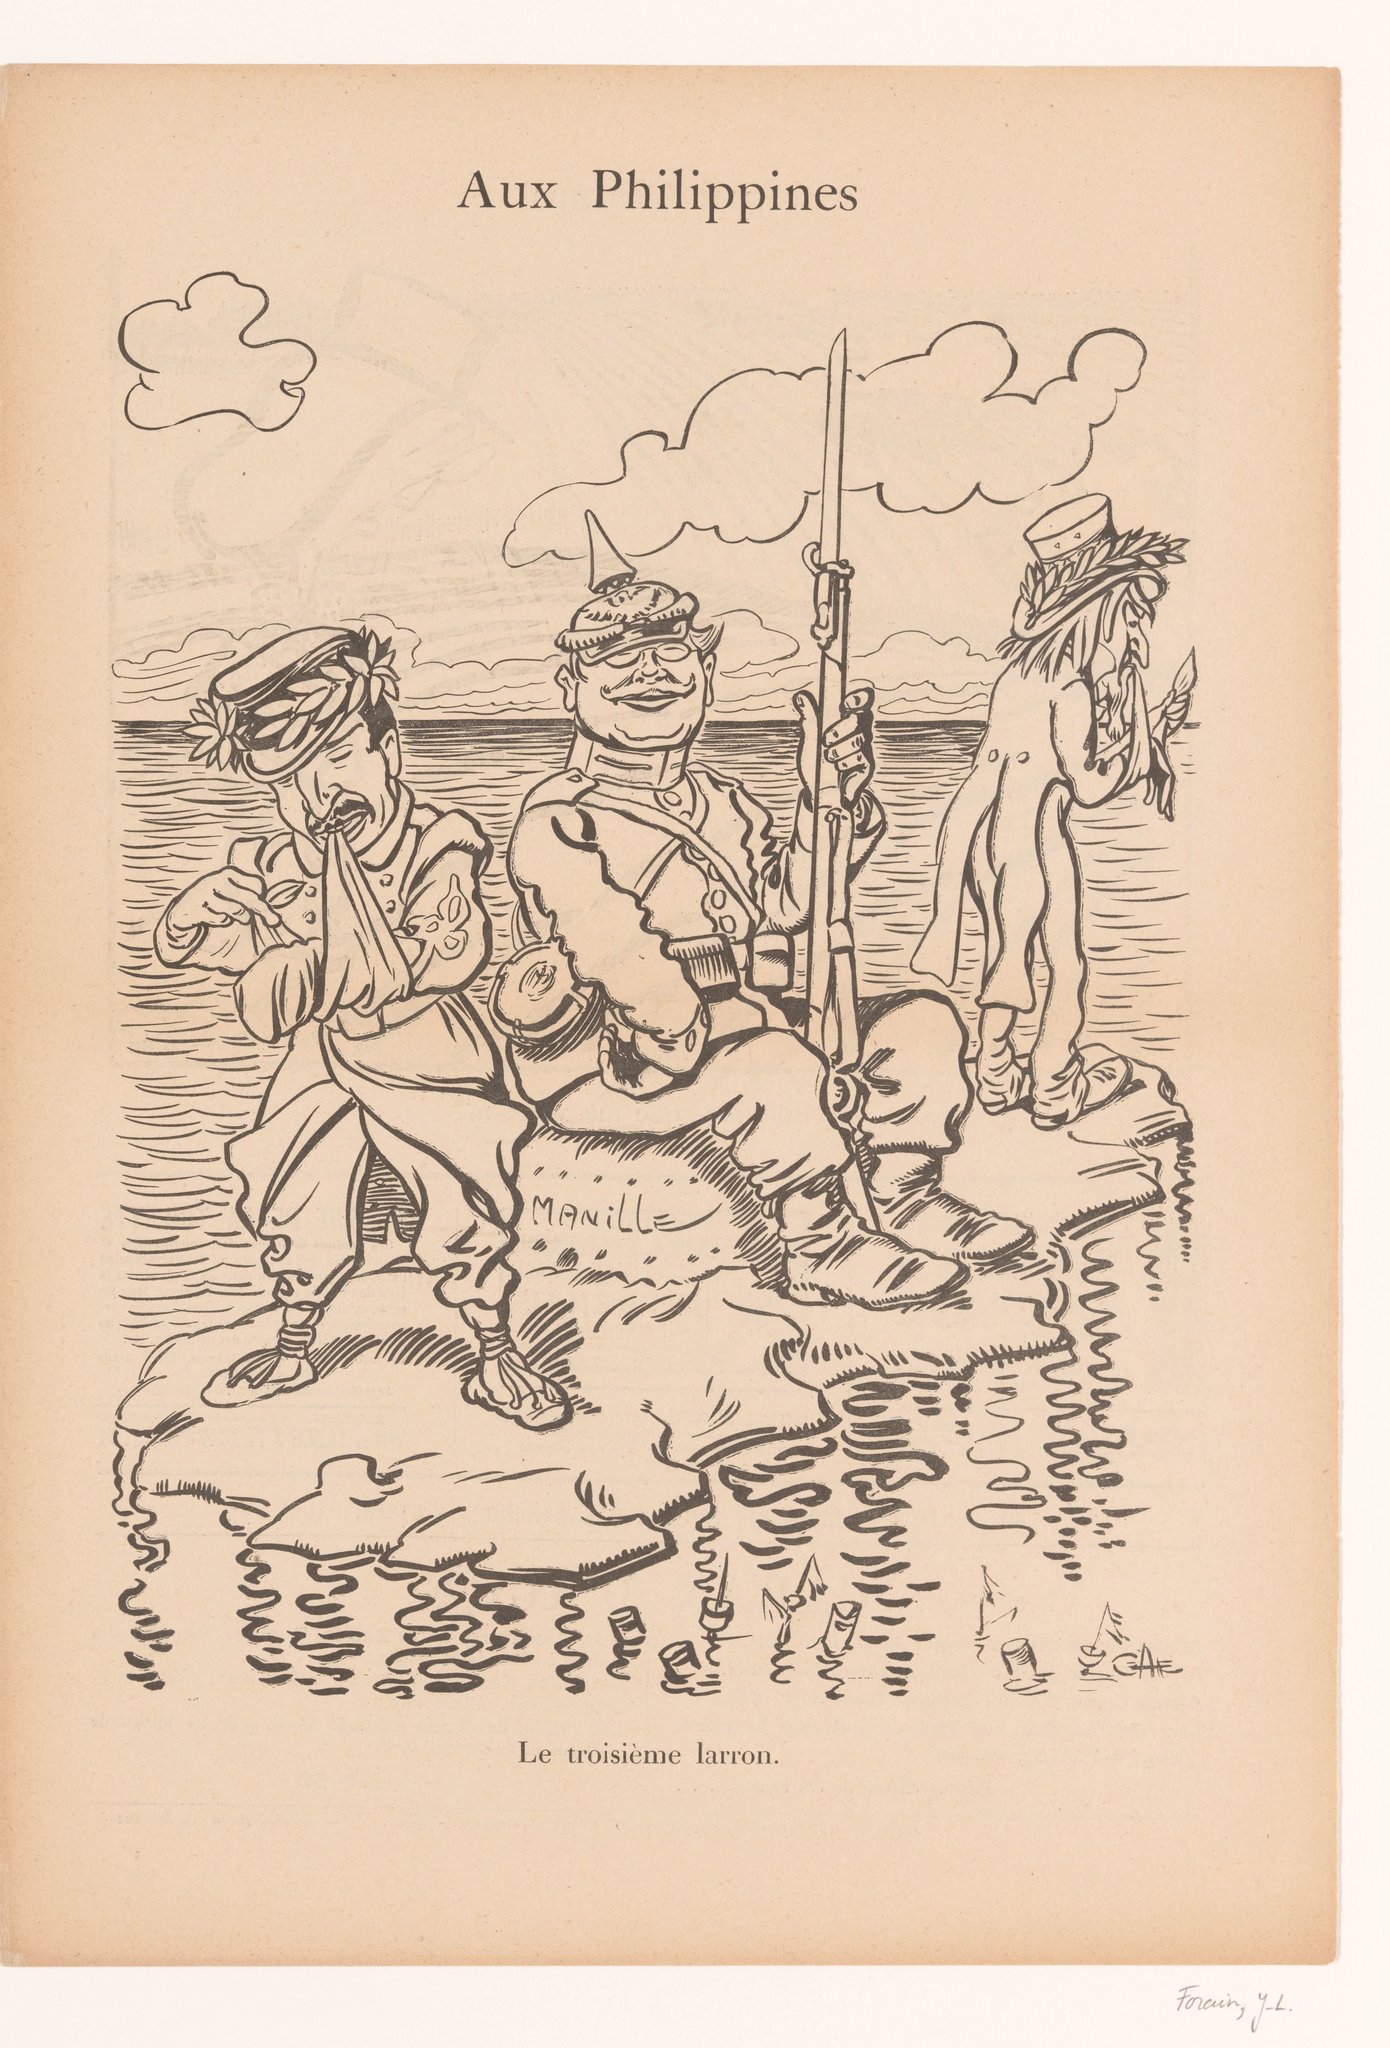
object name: cartoon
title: Karikatuur van drie figuren op de Filipijnen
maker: caran dache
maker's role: draughtsman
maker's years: 1859-1909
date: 1898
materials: paper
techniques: lithograph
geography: paris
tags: island, caricatures (human types), political caricatures and satires, philippines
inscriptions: date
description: Prent gebruikt voor: Psst...!, nr. 21, 25 juni 1898. Psst..! was een politieke weekkrant met antisemitische en anti-Dreyfus cartoons.